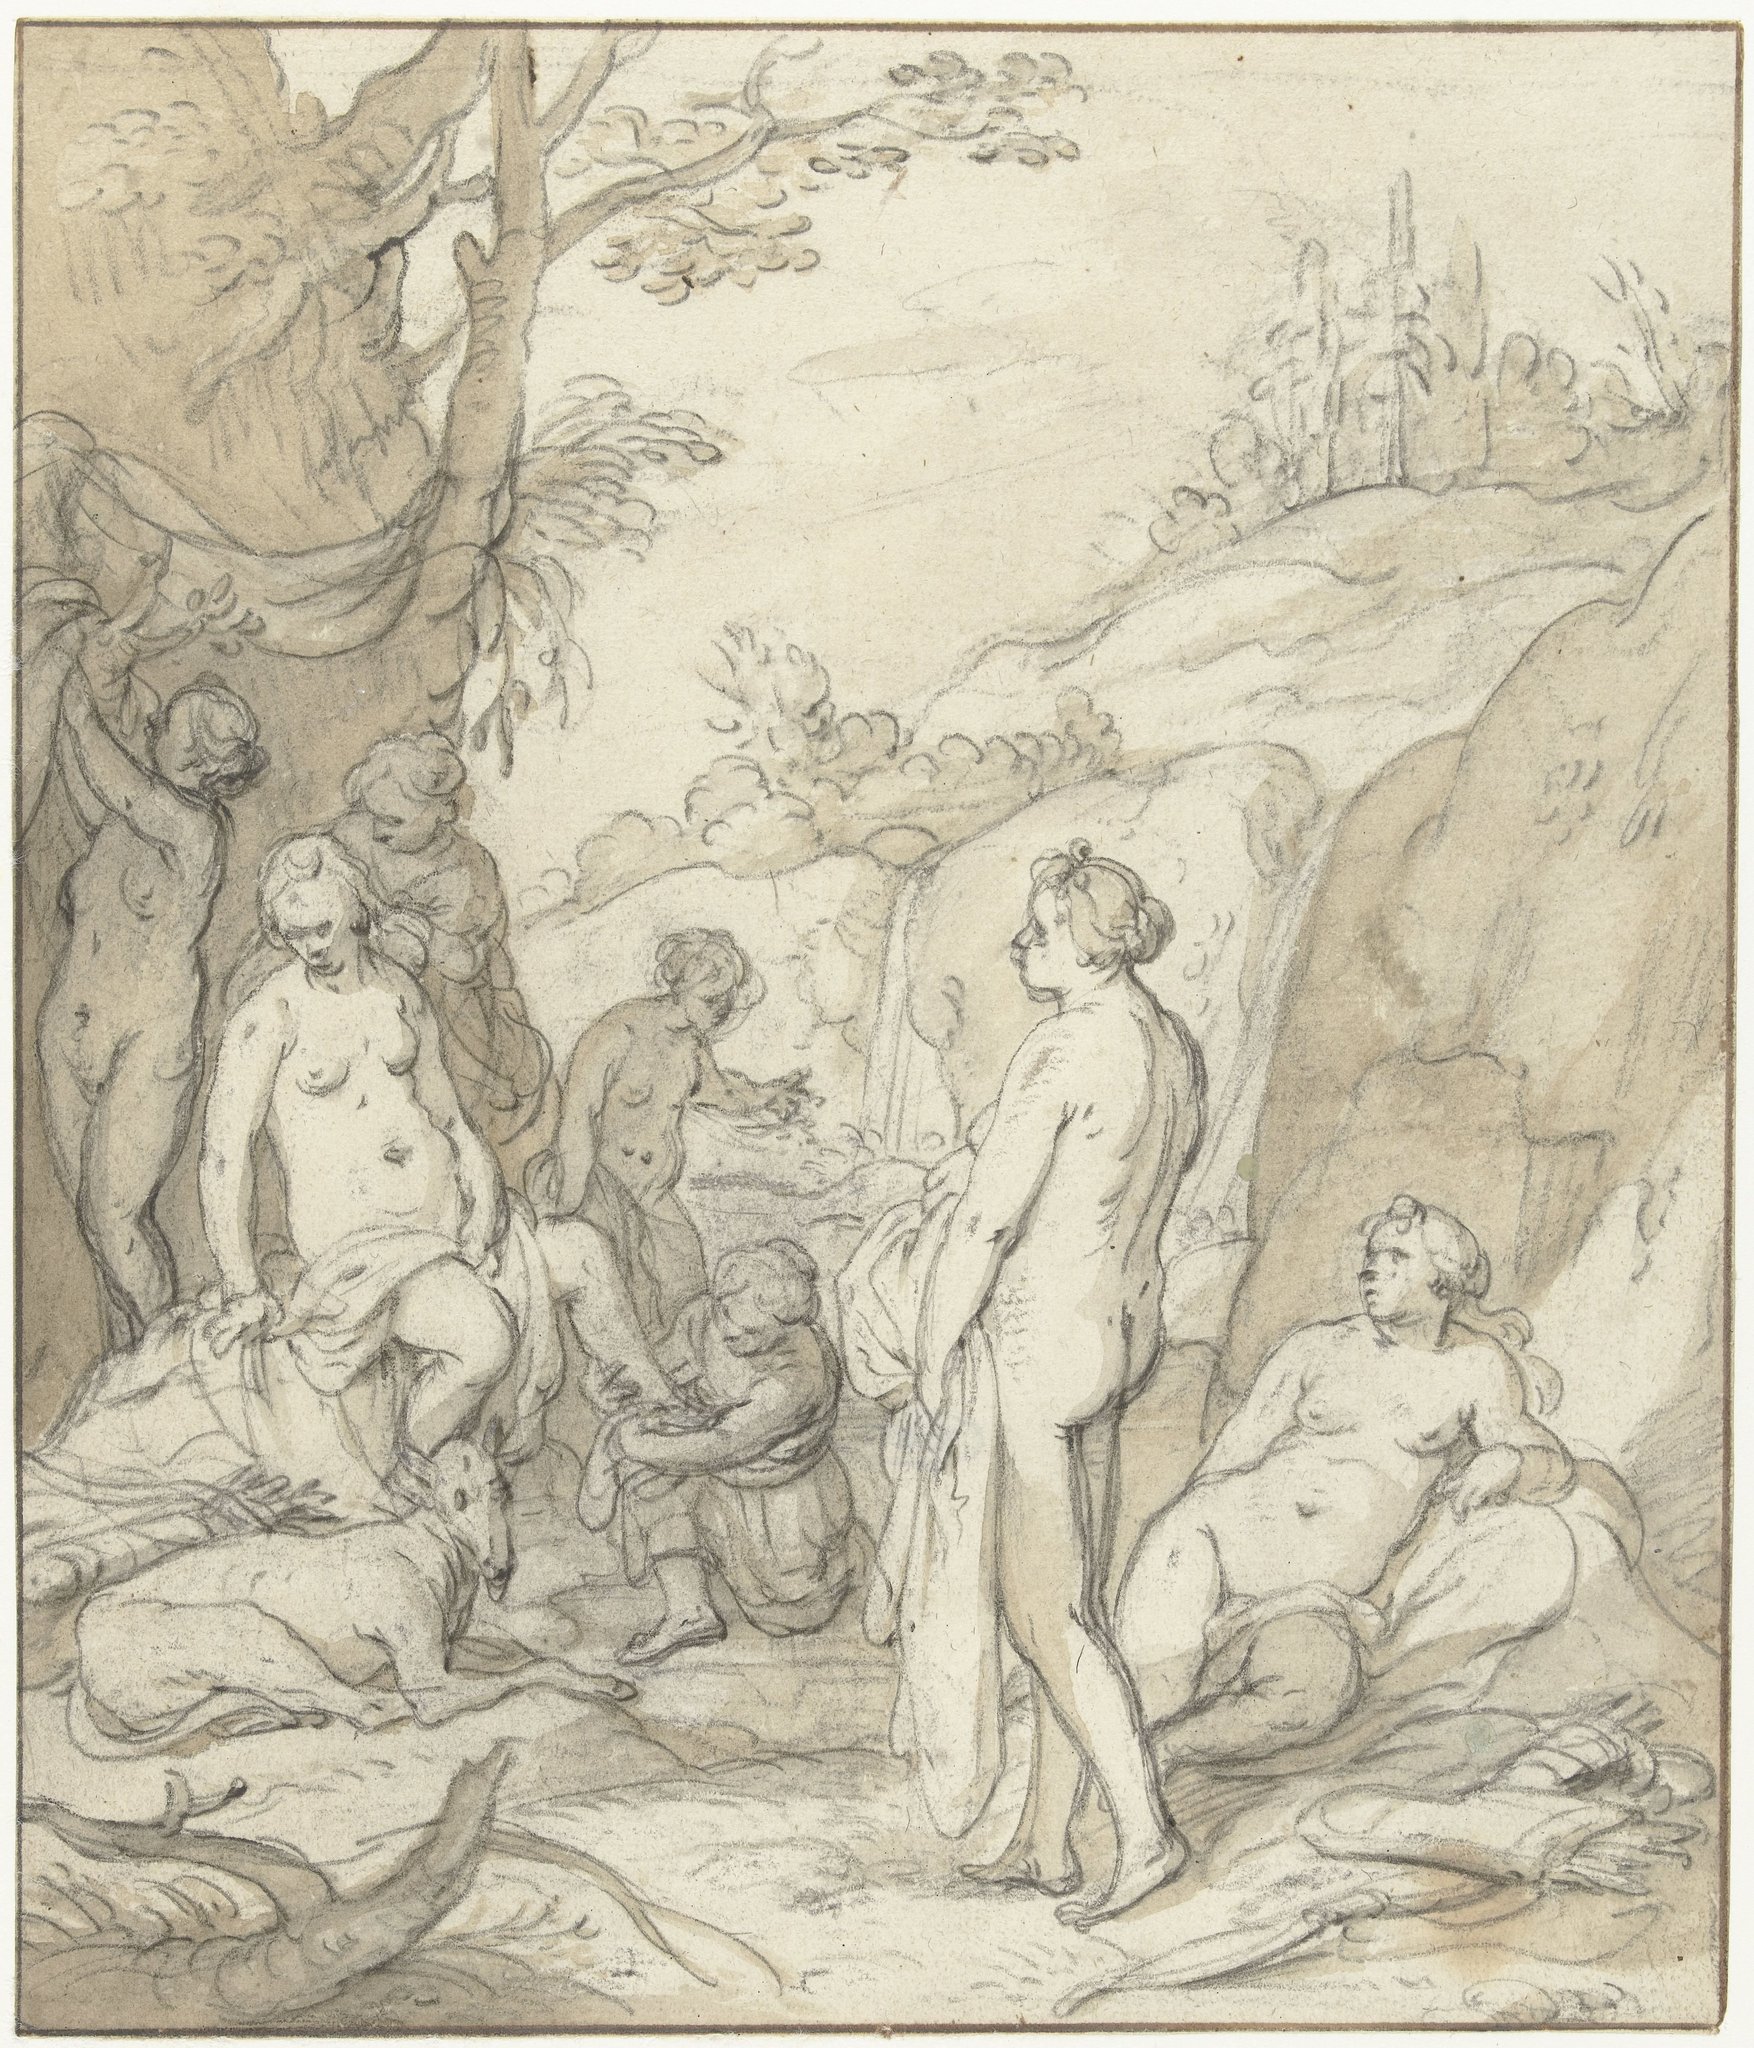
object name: drawing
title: Toilet van Diana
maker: abraham van diepenbeeck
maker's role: draughtsman, print maker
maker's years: 1596-1675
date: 1606-1675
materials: chalk, paper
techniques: brush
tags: diana bathing with her nymphs